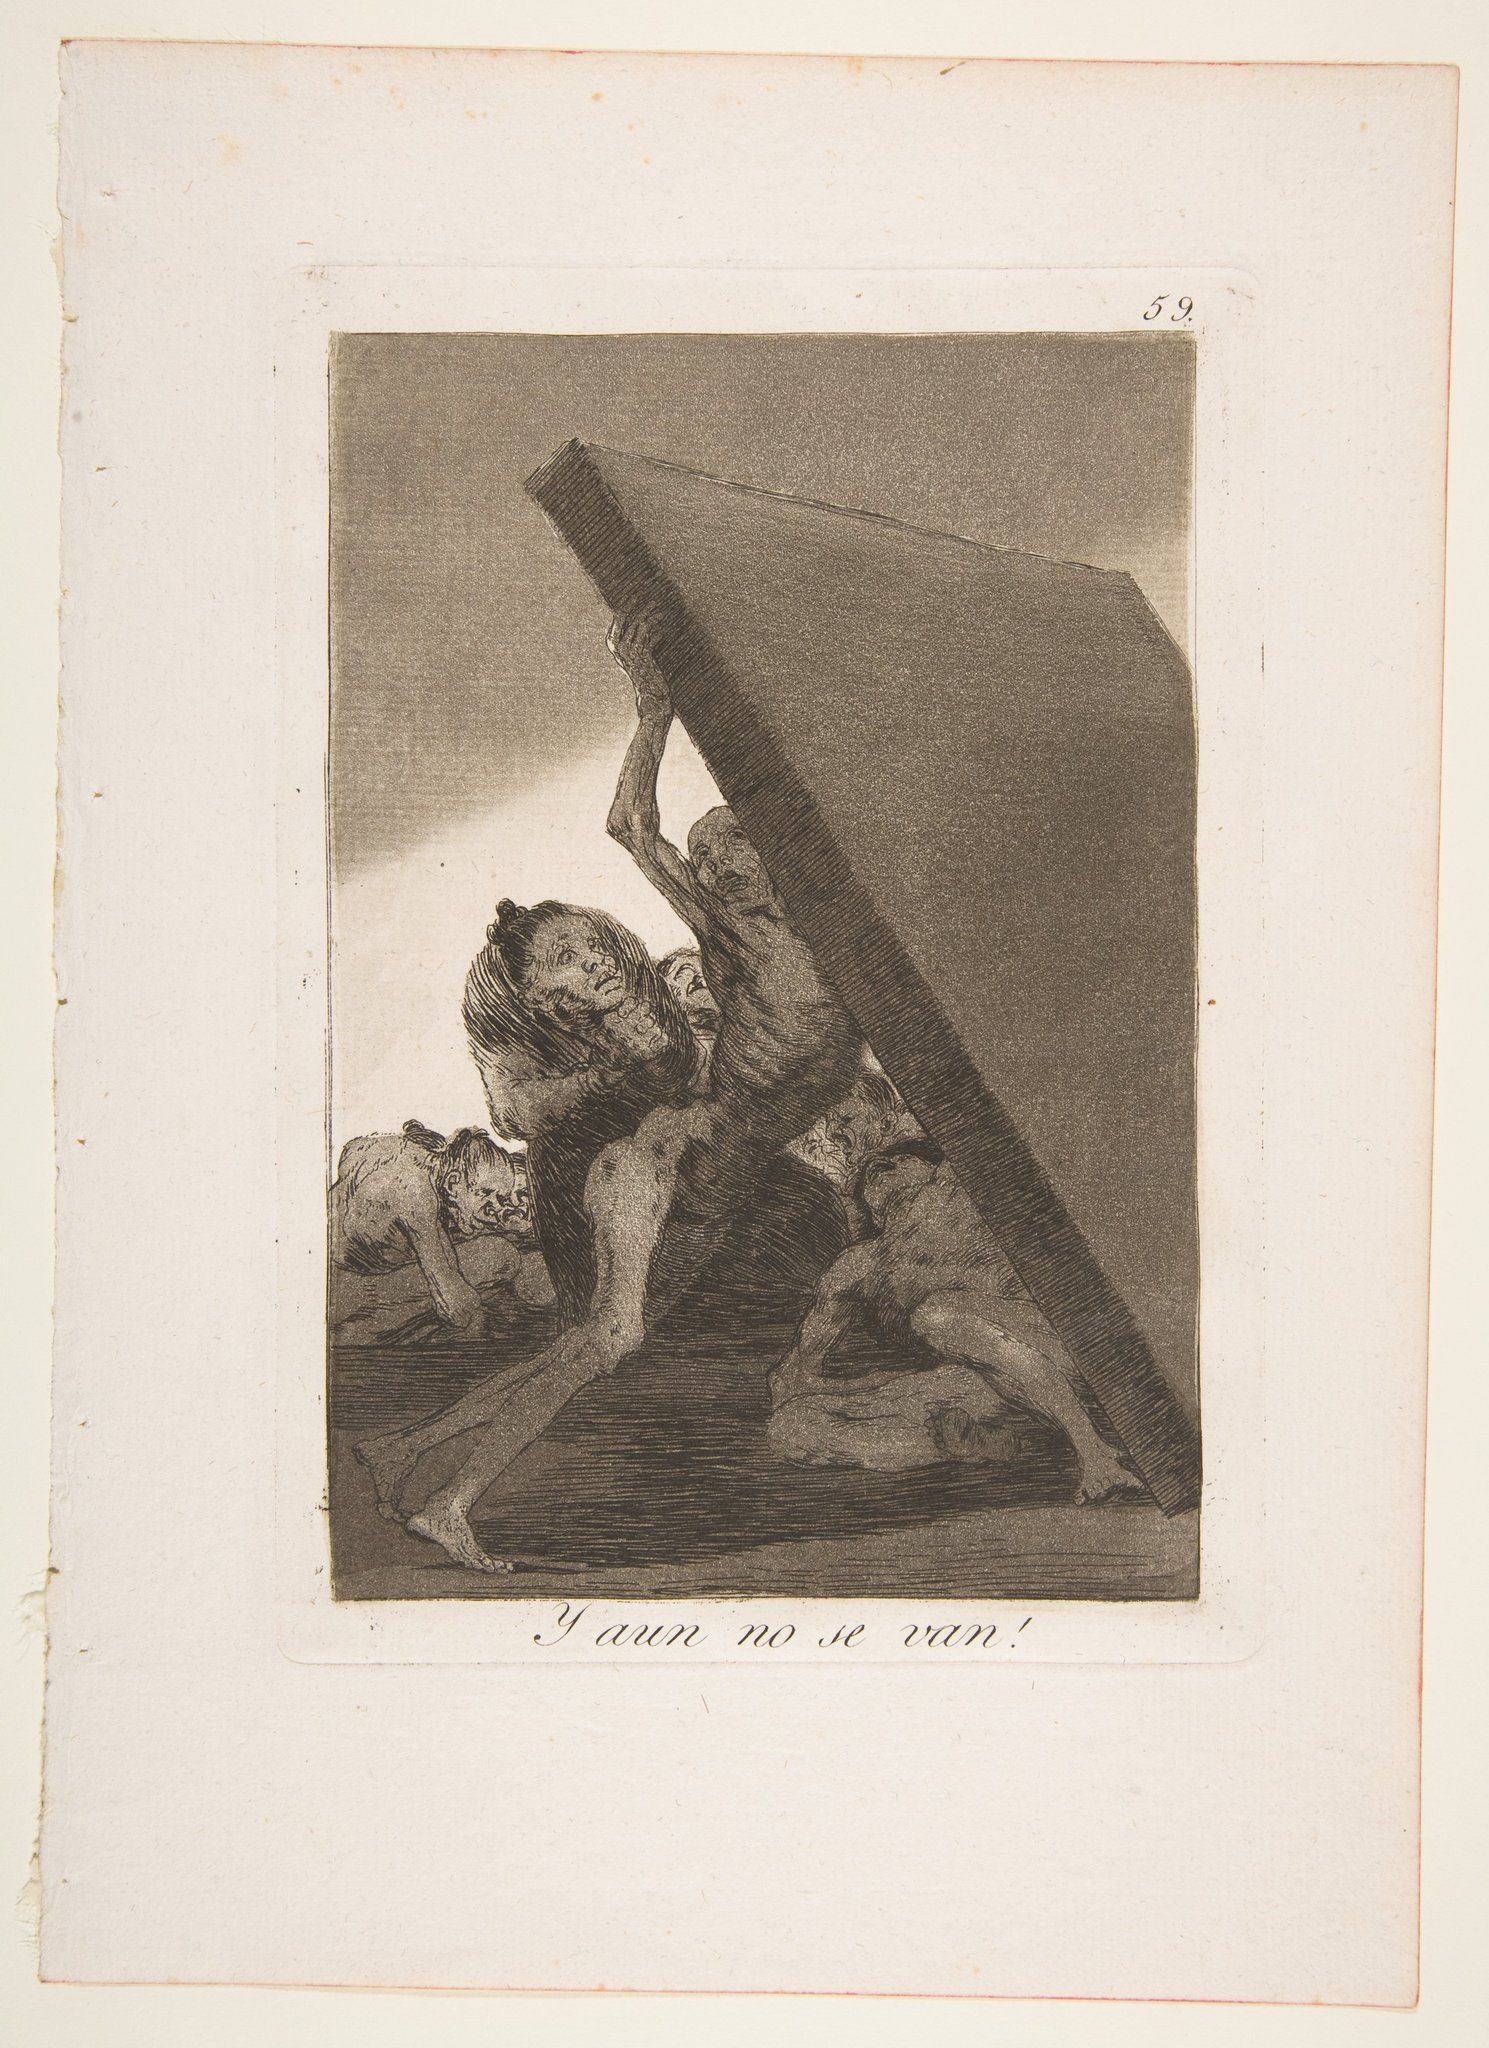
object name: print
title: Plate 59 from "Los Caprichos": And still they don't go! (Y aun no se van!)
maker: goya (francisco de goya y lucientes)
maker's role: artist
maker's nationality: spanish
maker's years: 1746-1828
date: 1799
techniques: aquatint, engraving, burnishing, etching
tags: fear,men,women